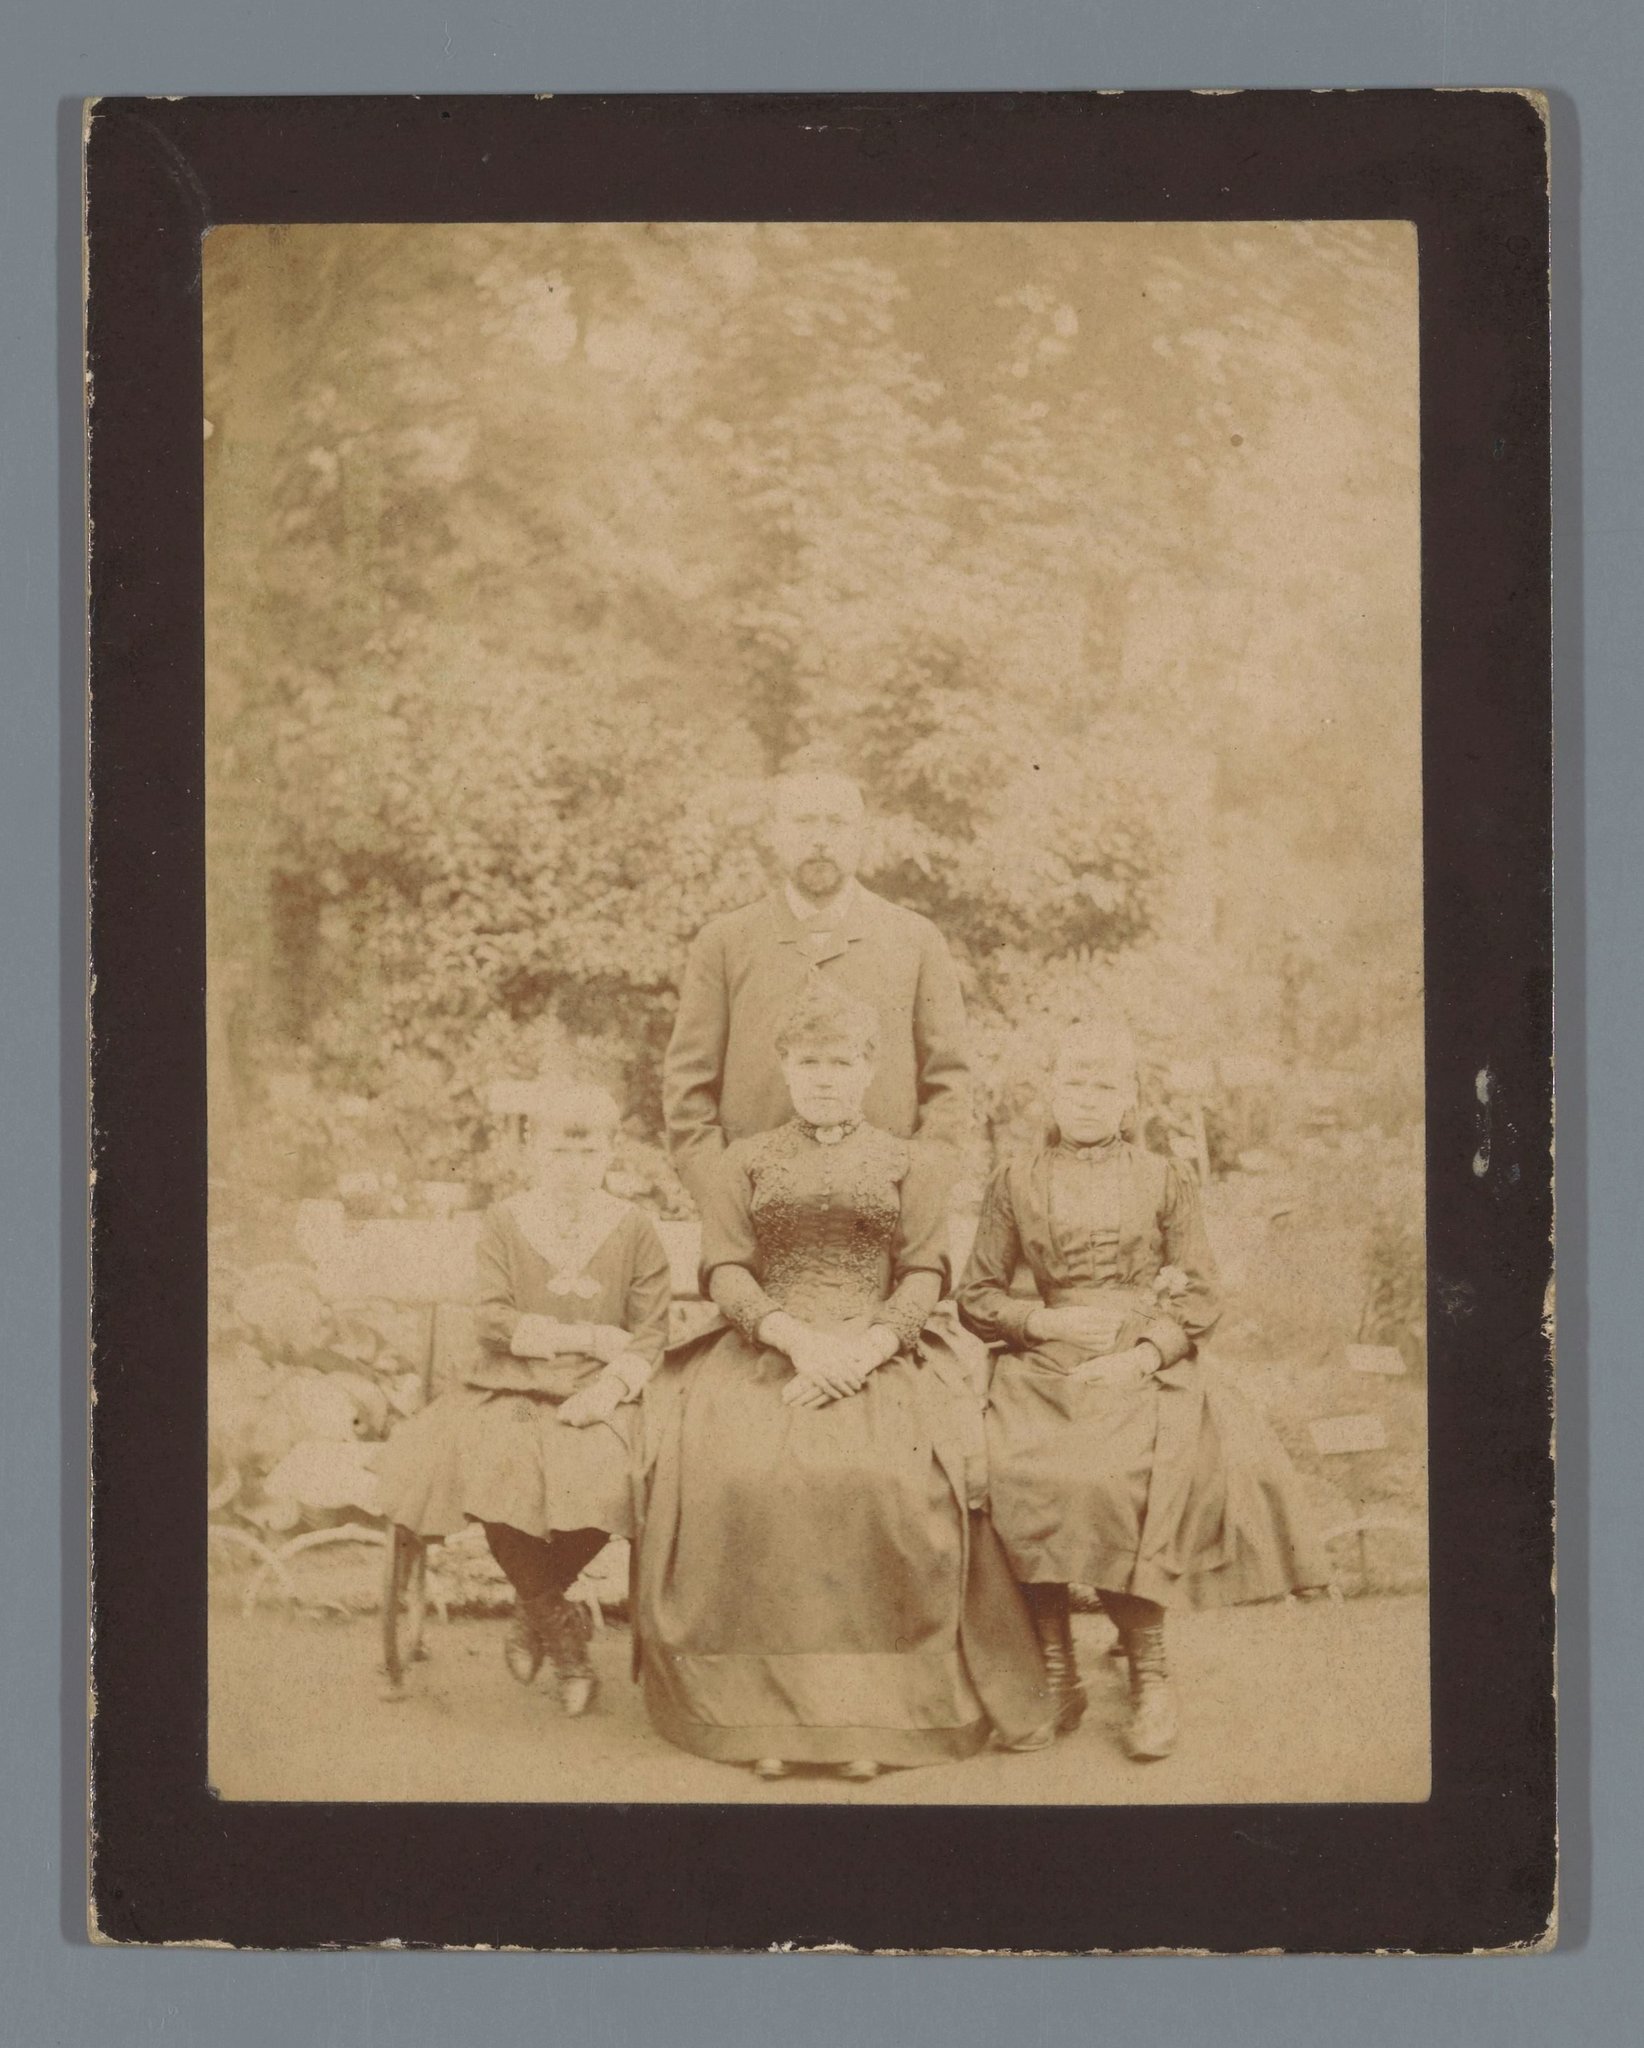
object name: photograph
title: Portret van een onbekend gezin in een tuin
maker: Anonymous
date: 1865-1890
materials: cardboard, photographic support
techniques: albumen print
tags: family group, especially parents with their child(ren), garden